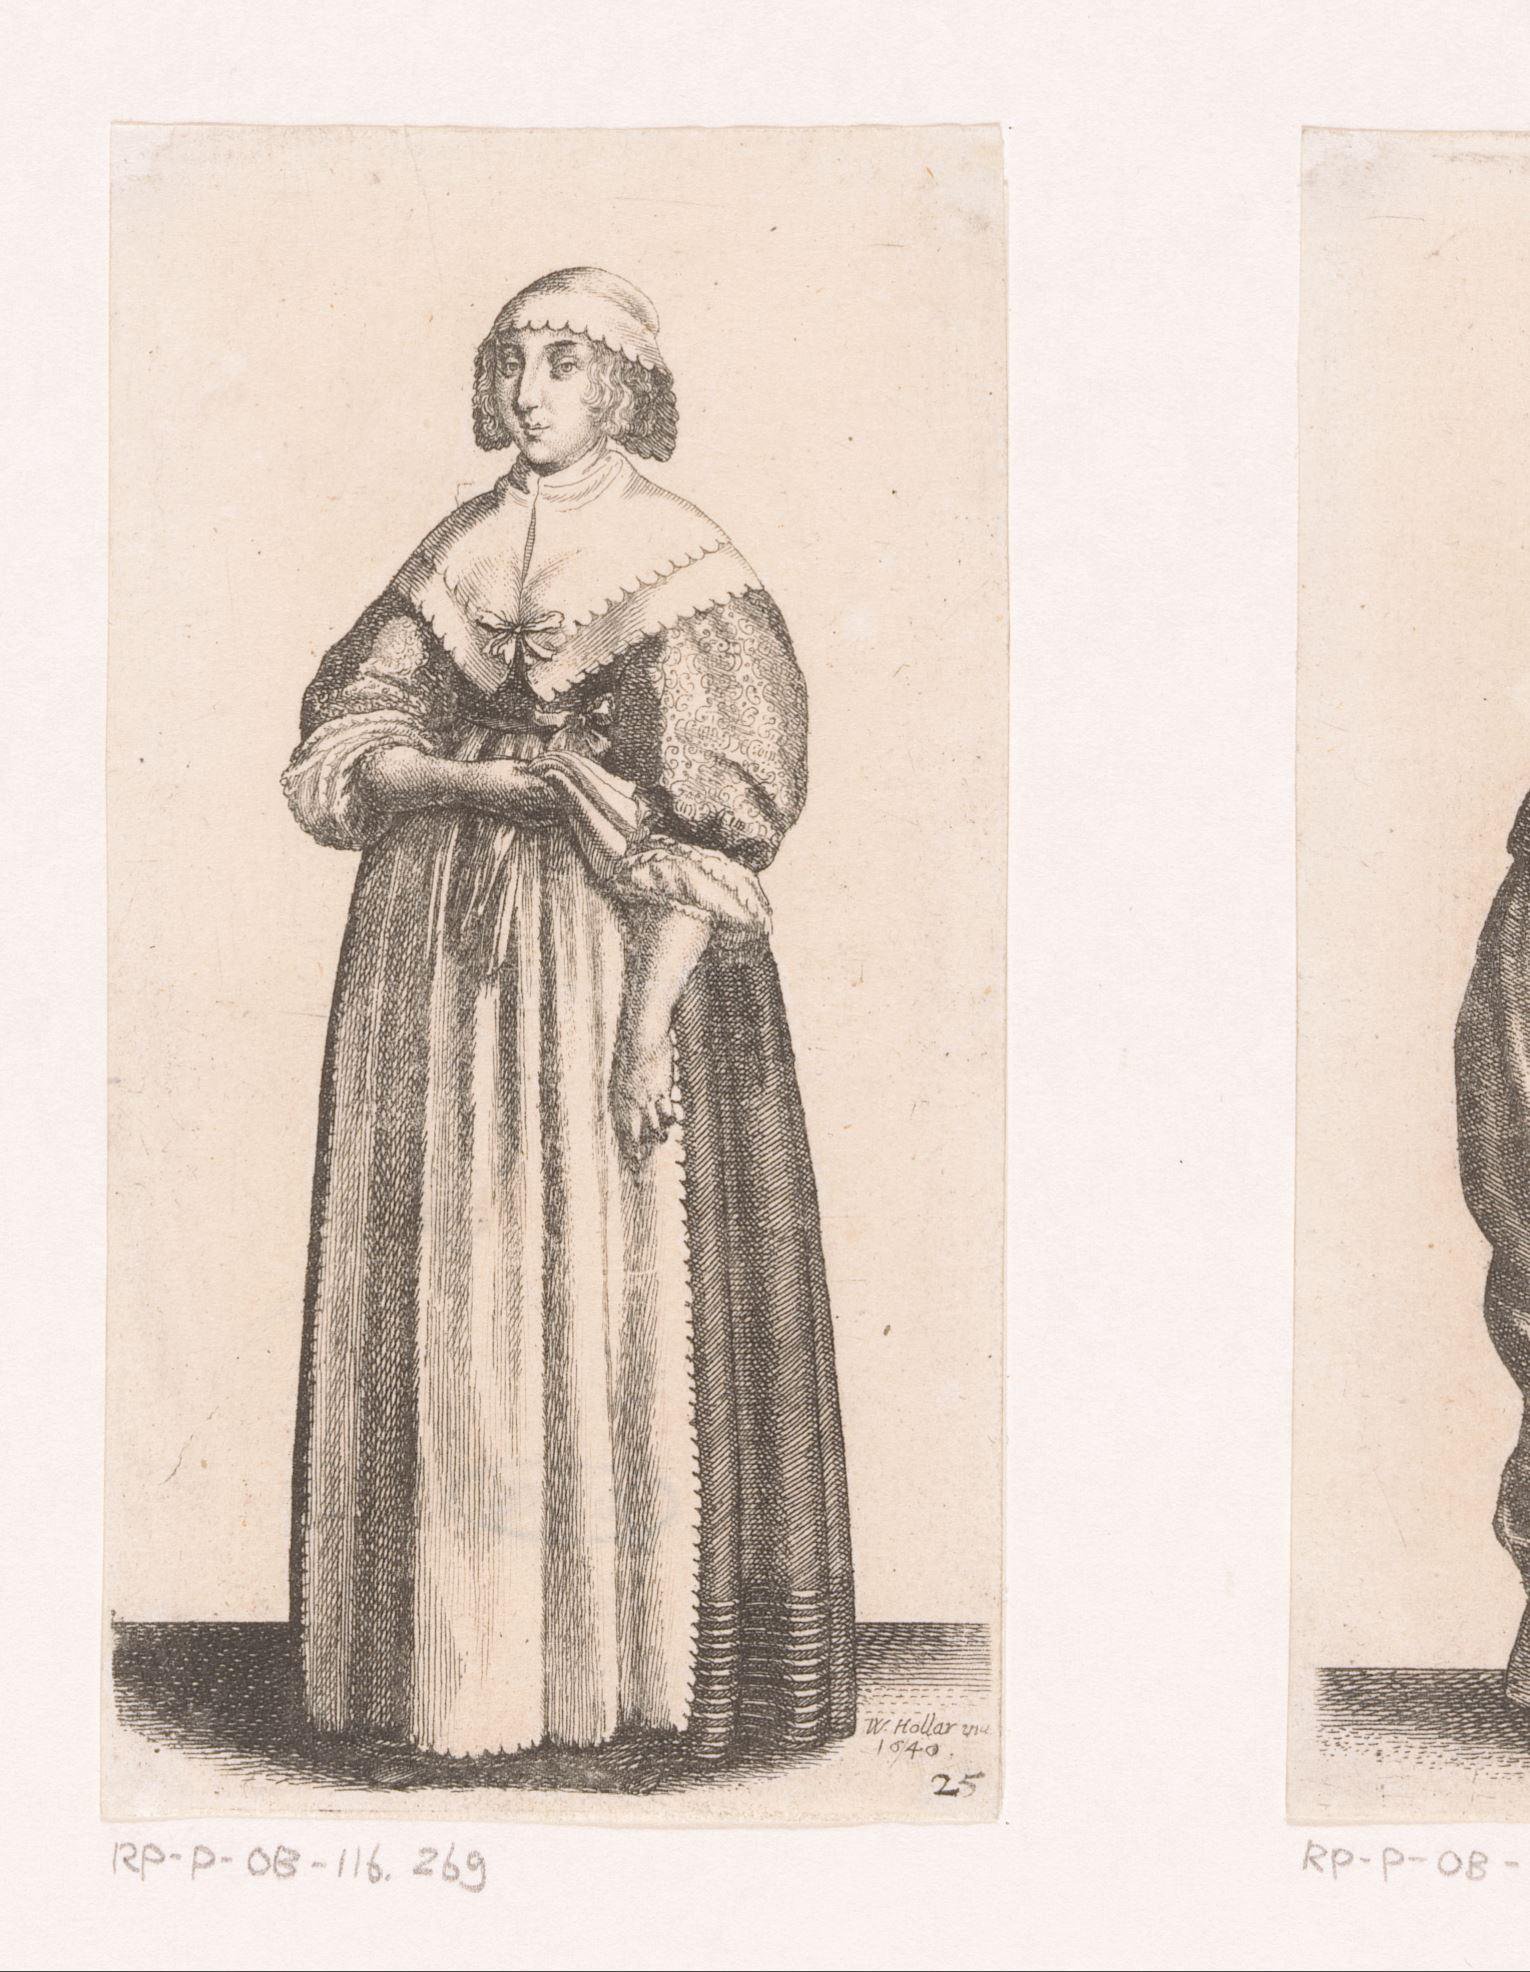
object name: costume print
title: Ornatus Muliebris Anglicanus / The Severall Habits of English Women, from the Nobilitie to the contry woman, they are in these times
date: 1640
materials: paper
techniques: etching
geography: london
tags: bow (ornamental part of clothing) (+ women's clothes), gloves, mittens (long gloves) (+ women's clothes), neck-gear ~ clothing (neckerchief) (+ women's clothes), europeans: englishmen (+ women), head-gear: cap (+ women's clothes), fashion, clothing (+ lace used for clothes), neck-gear: collar (+ women's clothes), fashion plates, clothes, costume (+ women's clothes), dress, gown (+ women's clothes), apron (+ women's clothes)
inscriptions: collector's mark: Lugt 2760, collector's mark: Lugt 2228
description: Engelse vrouw met een mutsje waarvan de geschulpte rand over het voorhoofd komt. Over de schouders een dubbele halsdoek met geschulpte rand, in het midden vastgebonden met een strik. Handschoenen in haar rechterhand.